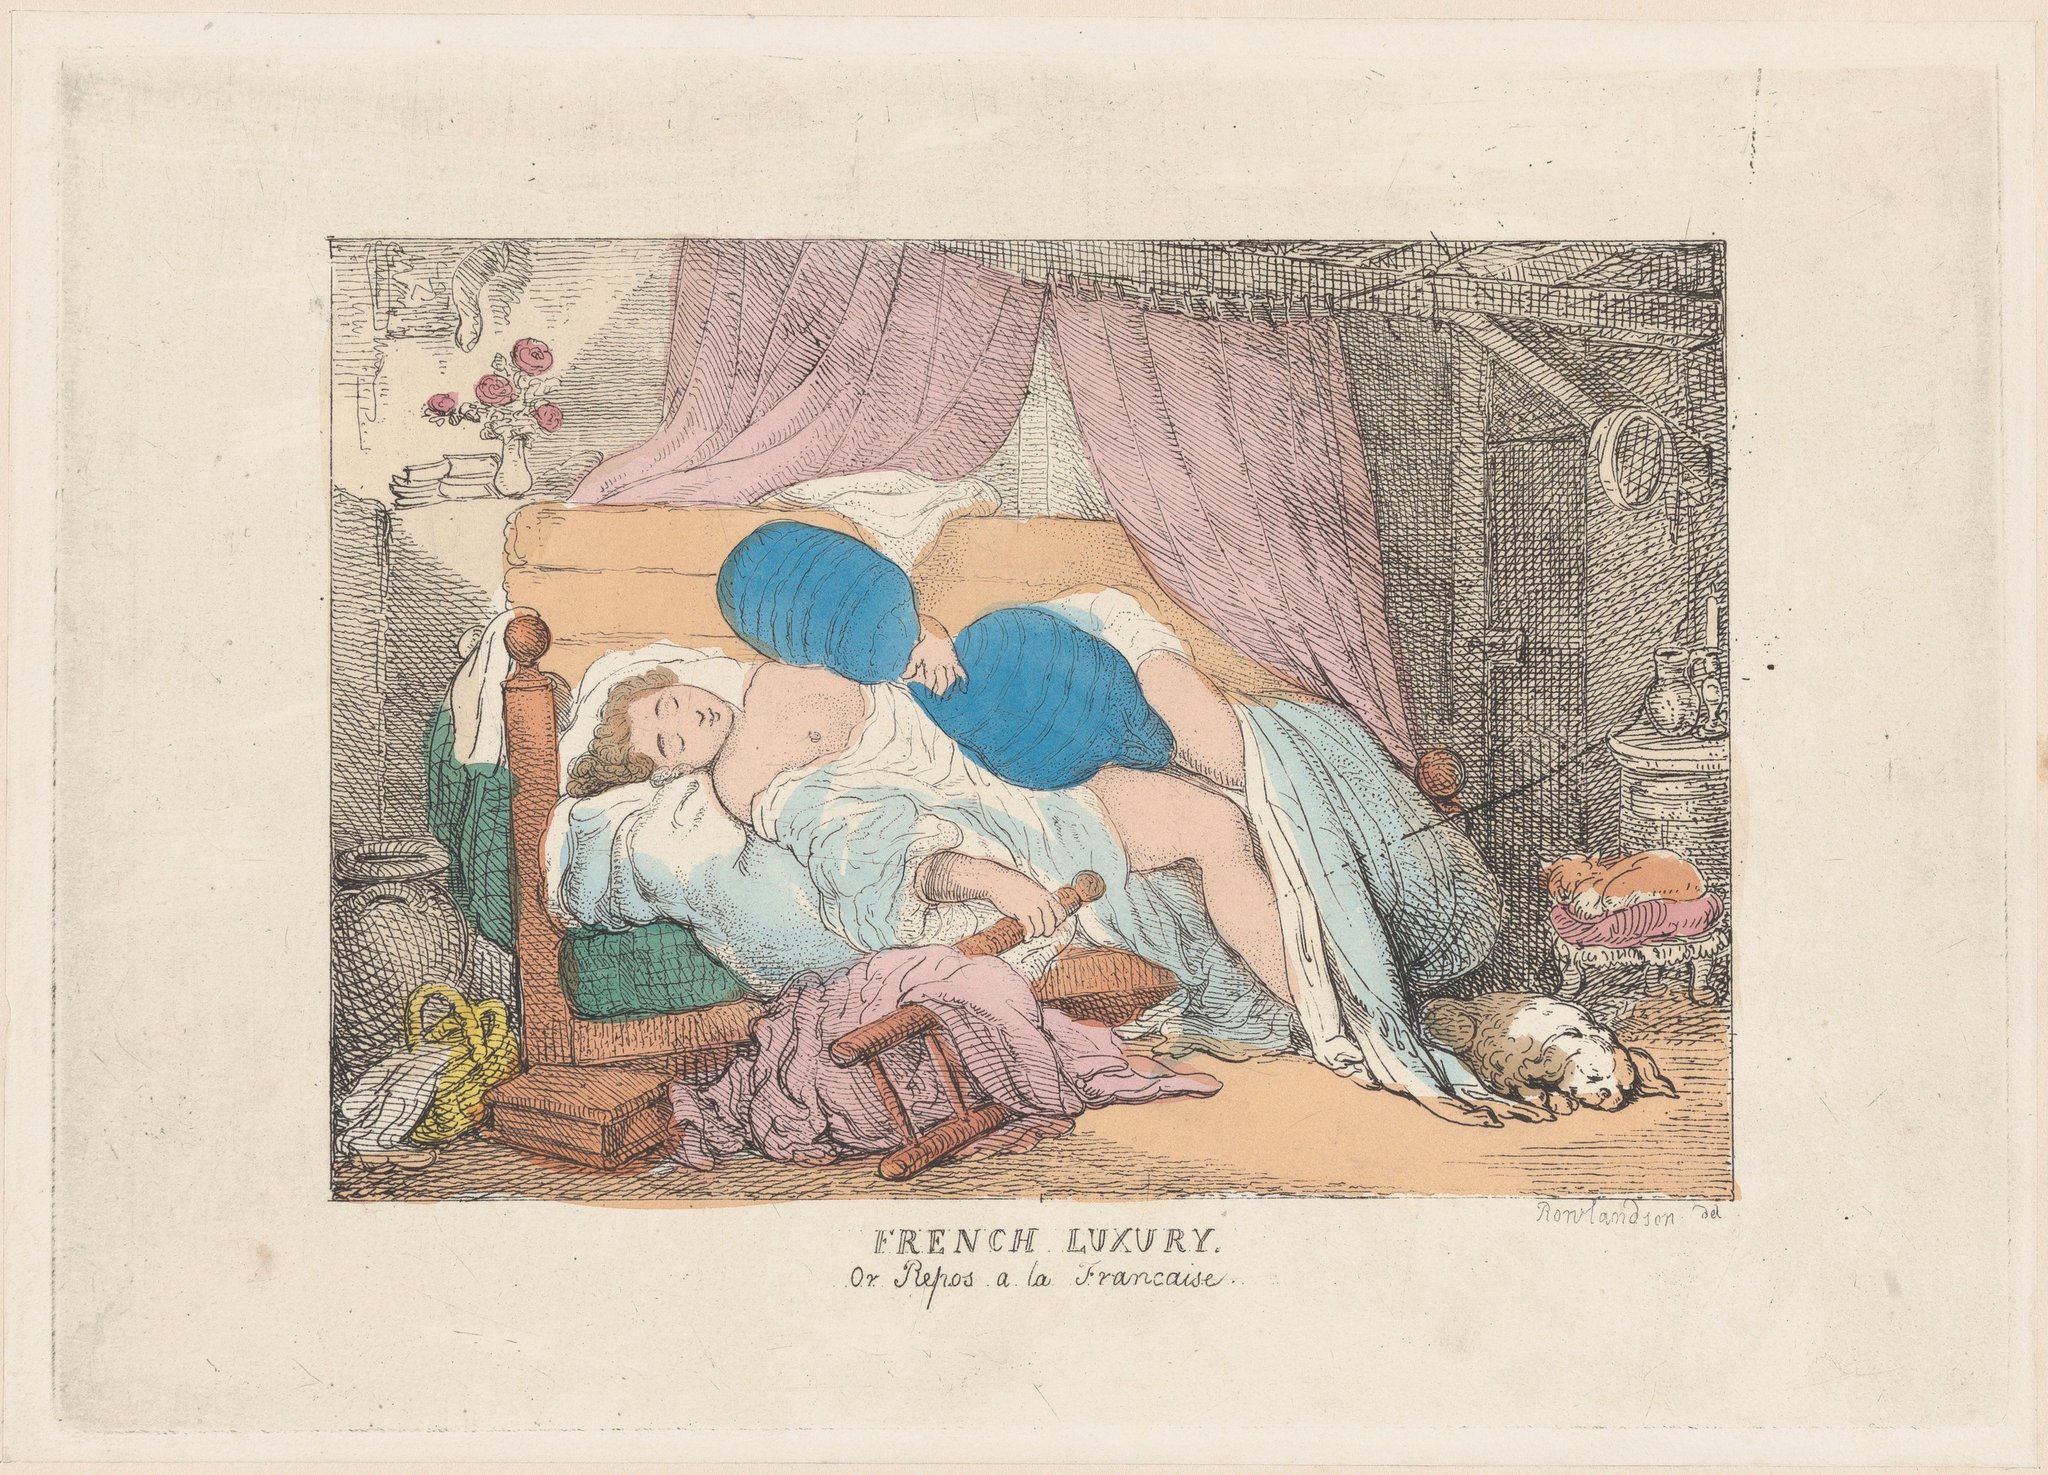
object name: print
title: French Luxury, or Repos a la Francaise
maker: thomas rowlandson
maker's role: artist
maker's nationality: british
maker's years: 1757-1827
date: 1800-1820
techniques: etching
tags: satire,sleeping,women,dogs,beds